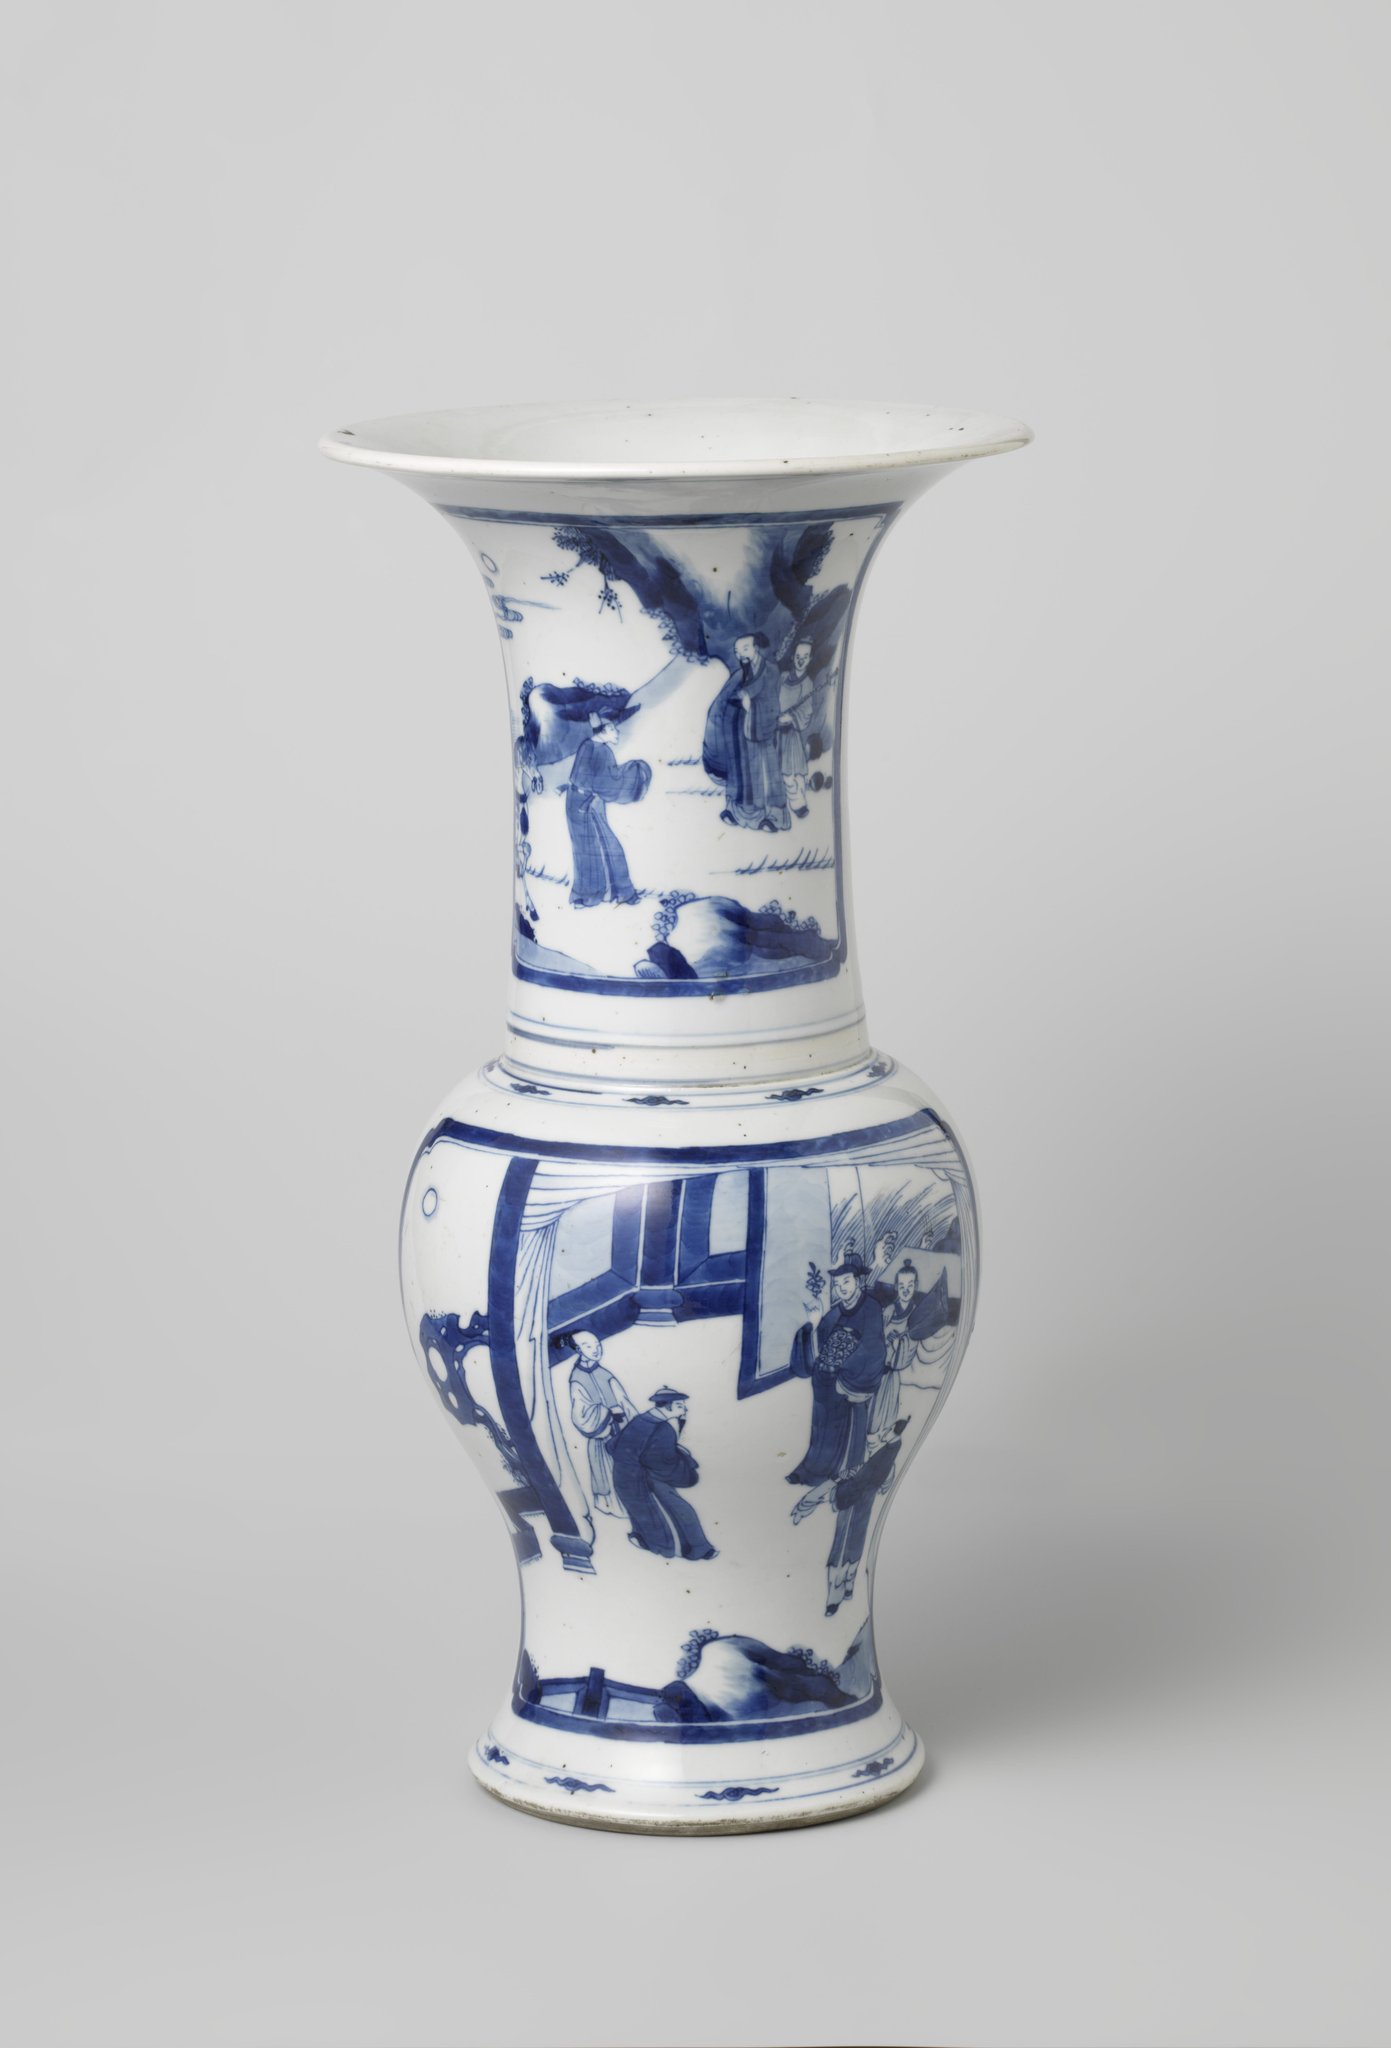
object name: vase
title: Baluster beaker vase with four narrative scenes in panels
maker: Anonymous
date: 1680-1720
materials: cobalt, glaze, paint, porcelain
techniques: firing, turning, vitrification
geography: china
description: Balustervormige bekervaas van porselein met een trompetvormige mond, beschilderd in onderglazuur blauw. Op de buik twee grote cartouches met ingeknepen hoeken met verhalende voorstellingen: een ontmoeting tussen een geleerde en een hoogwaardigheidsbekleder in een interieur en twee geleerden in een omheinde tuin kijkend naar een stier, gepresenteerd door een bediende. Op de hals ook twee voorstellingen: een hoogwaardigheidsbekleder op een terras voor een paviljoen met twee bedienden en een ontmoeting tussen een geleerde en een hoogwaardigheidsbekleder in een landschap. Rond de voet, op de schouder en de buitenrand een band met een wolkmotief. Blauw-wit.